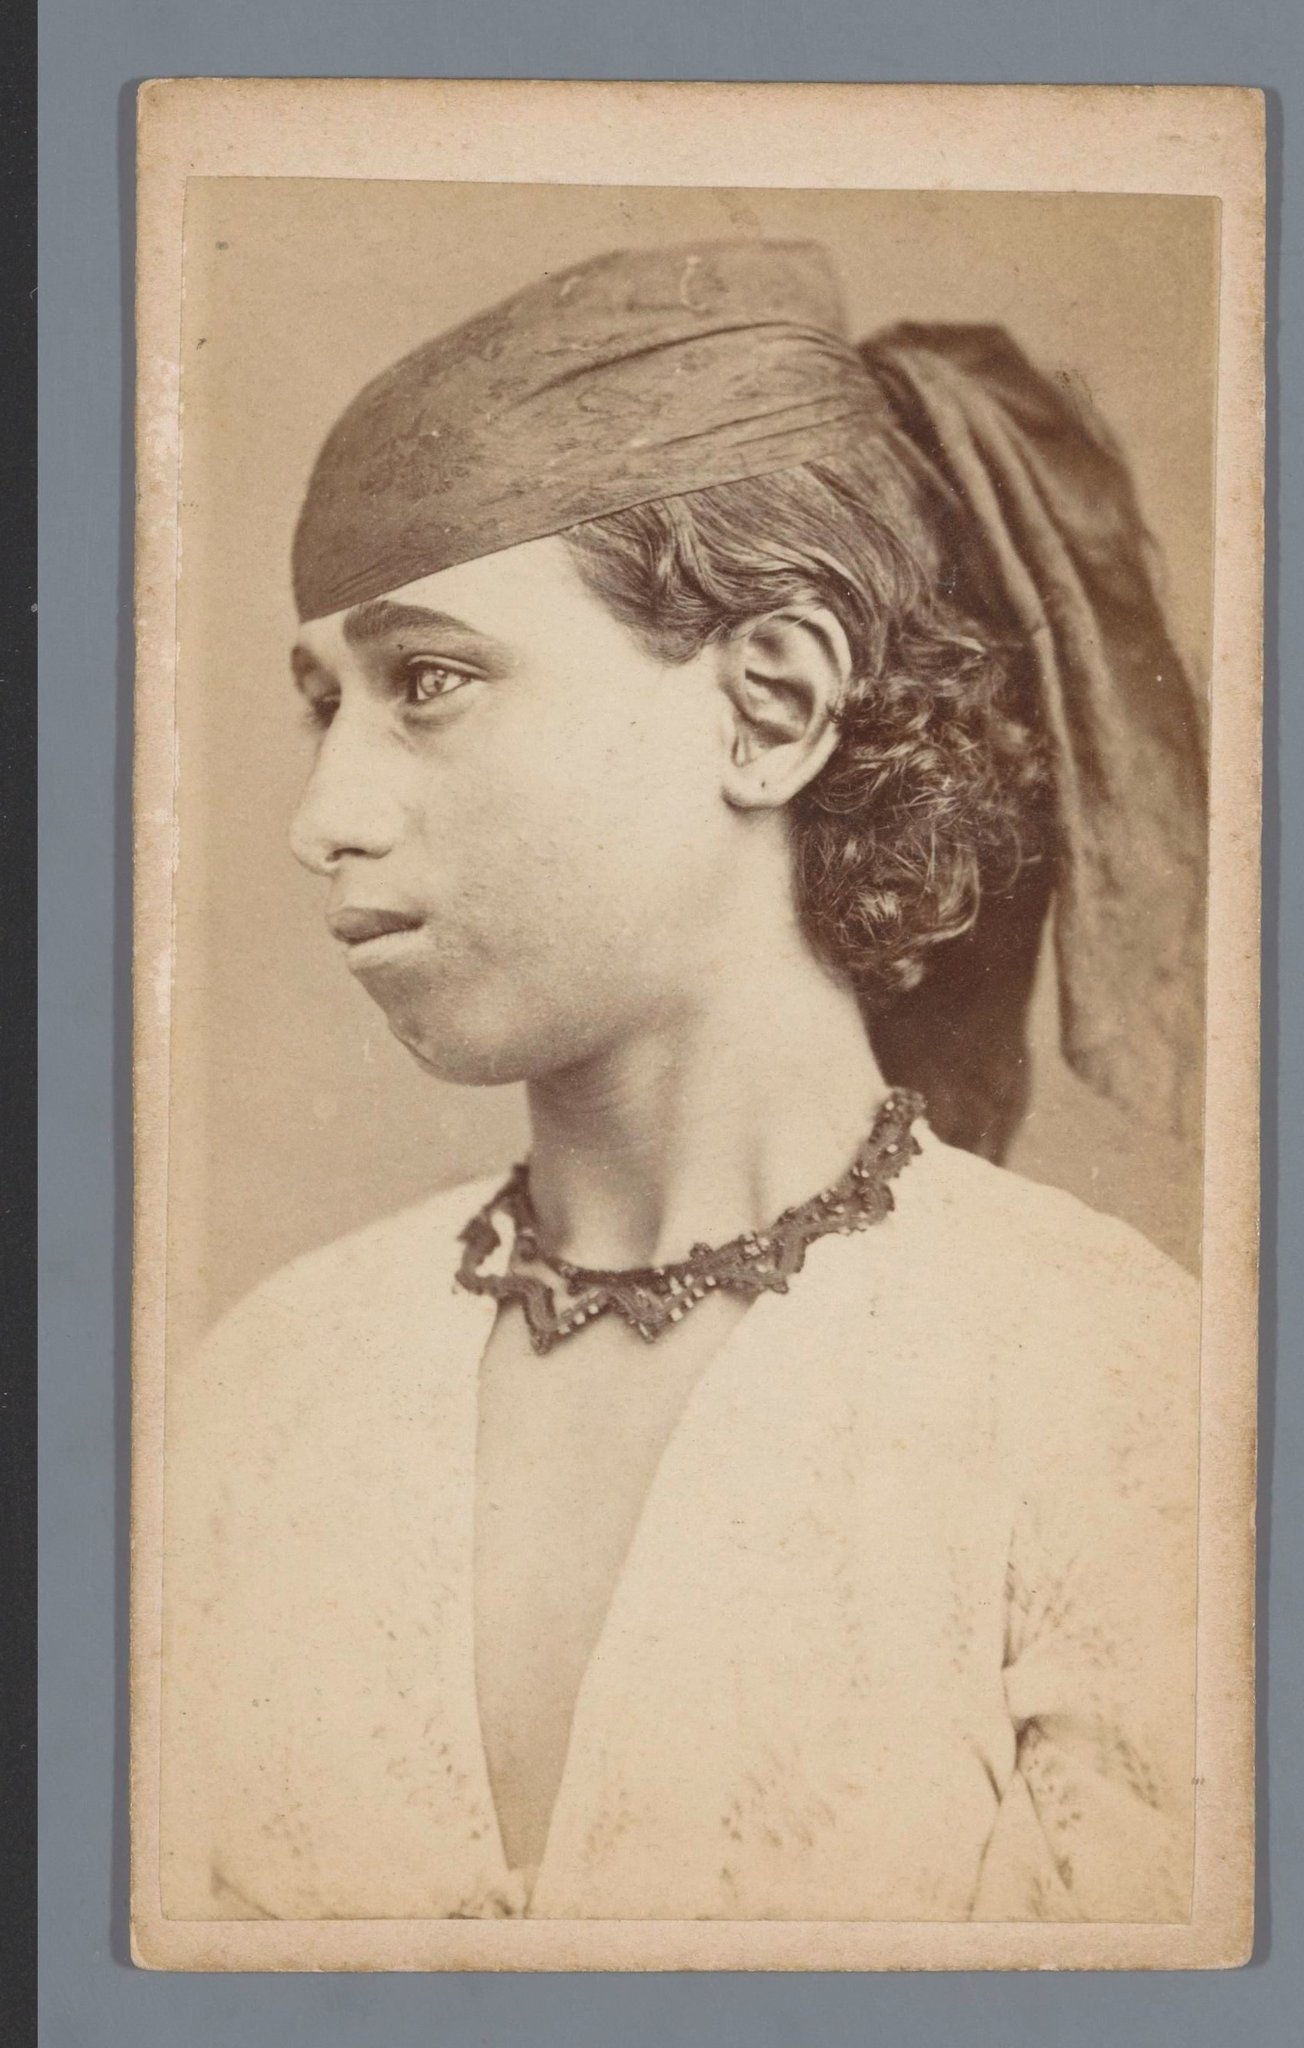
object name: photograph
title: Jong Arabisch meisje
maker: Anonymous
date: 1870-1900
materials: cardboard, paper, photographic support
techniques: albumen print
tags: historical persons not known by name - bb - woman